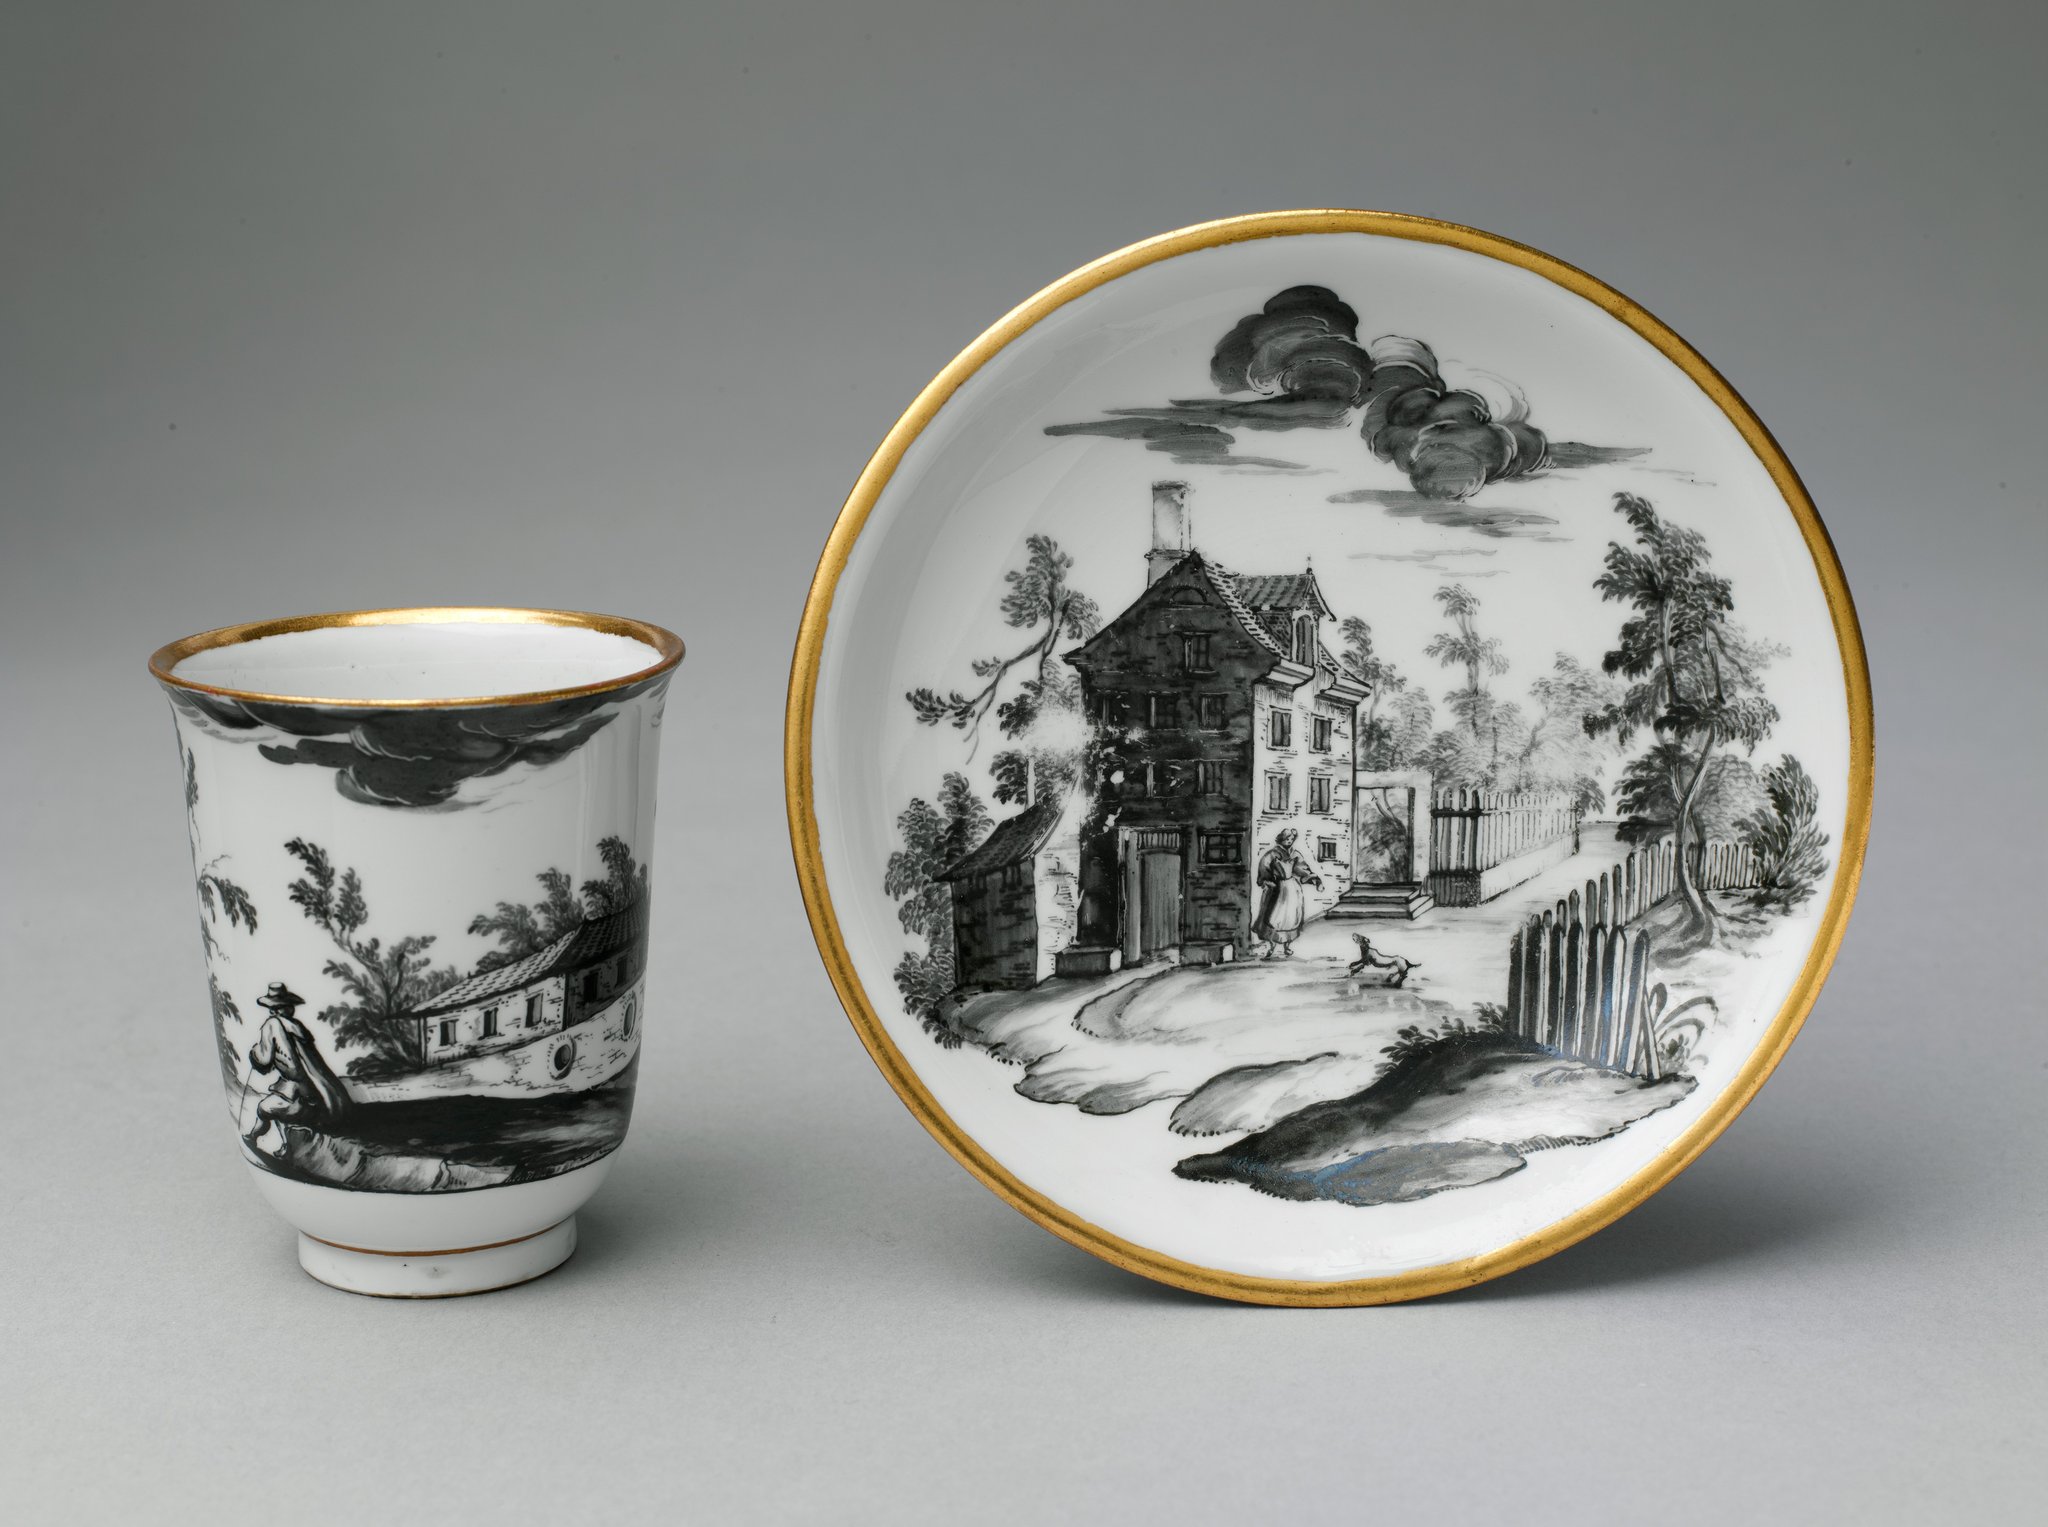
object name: beaker and saucer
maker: vienna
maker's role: manufactory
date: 1725-1735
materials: hard paste porcelain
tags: human figures,houses,dogs